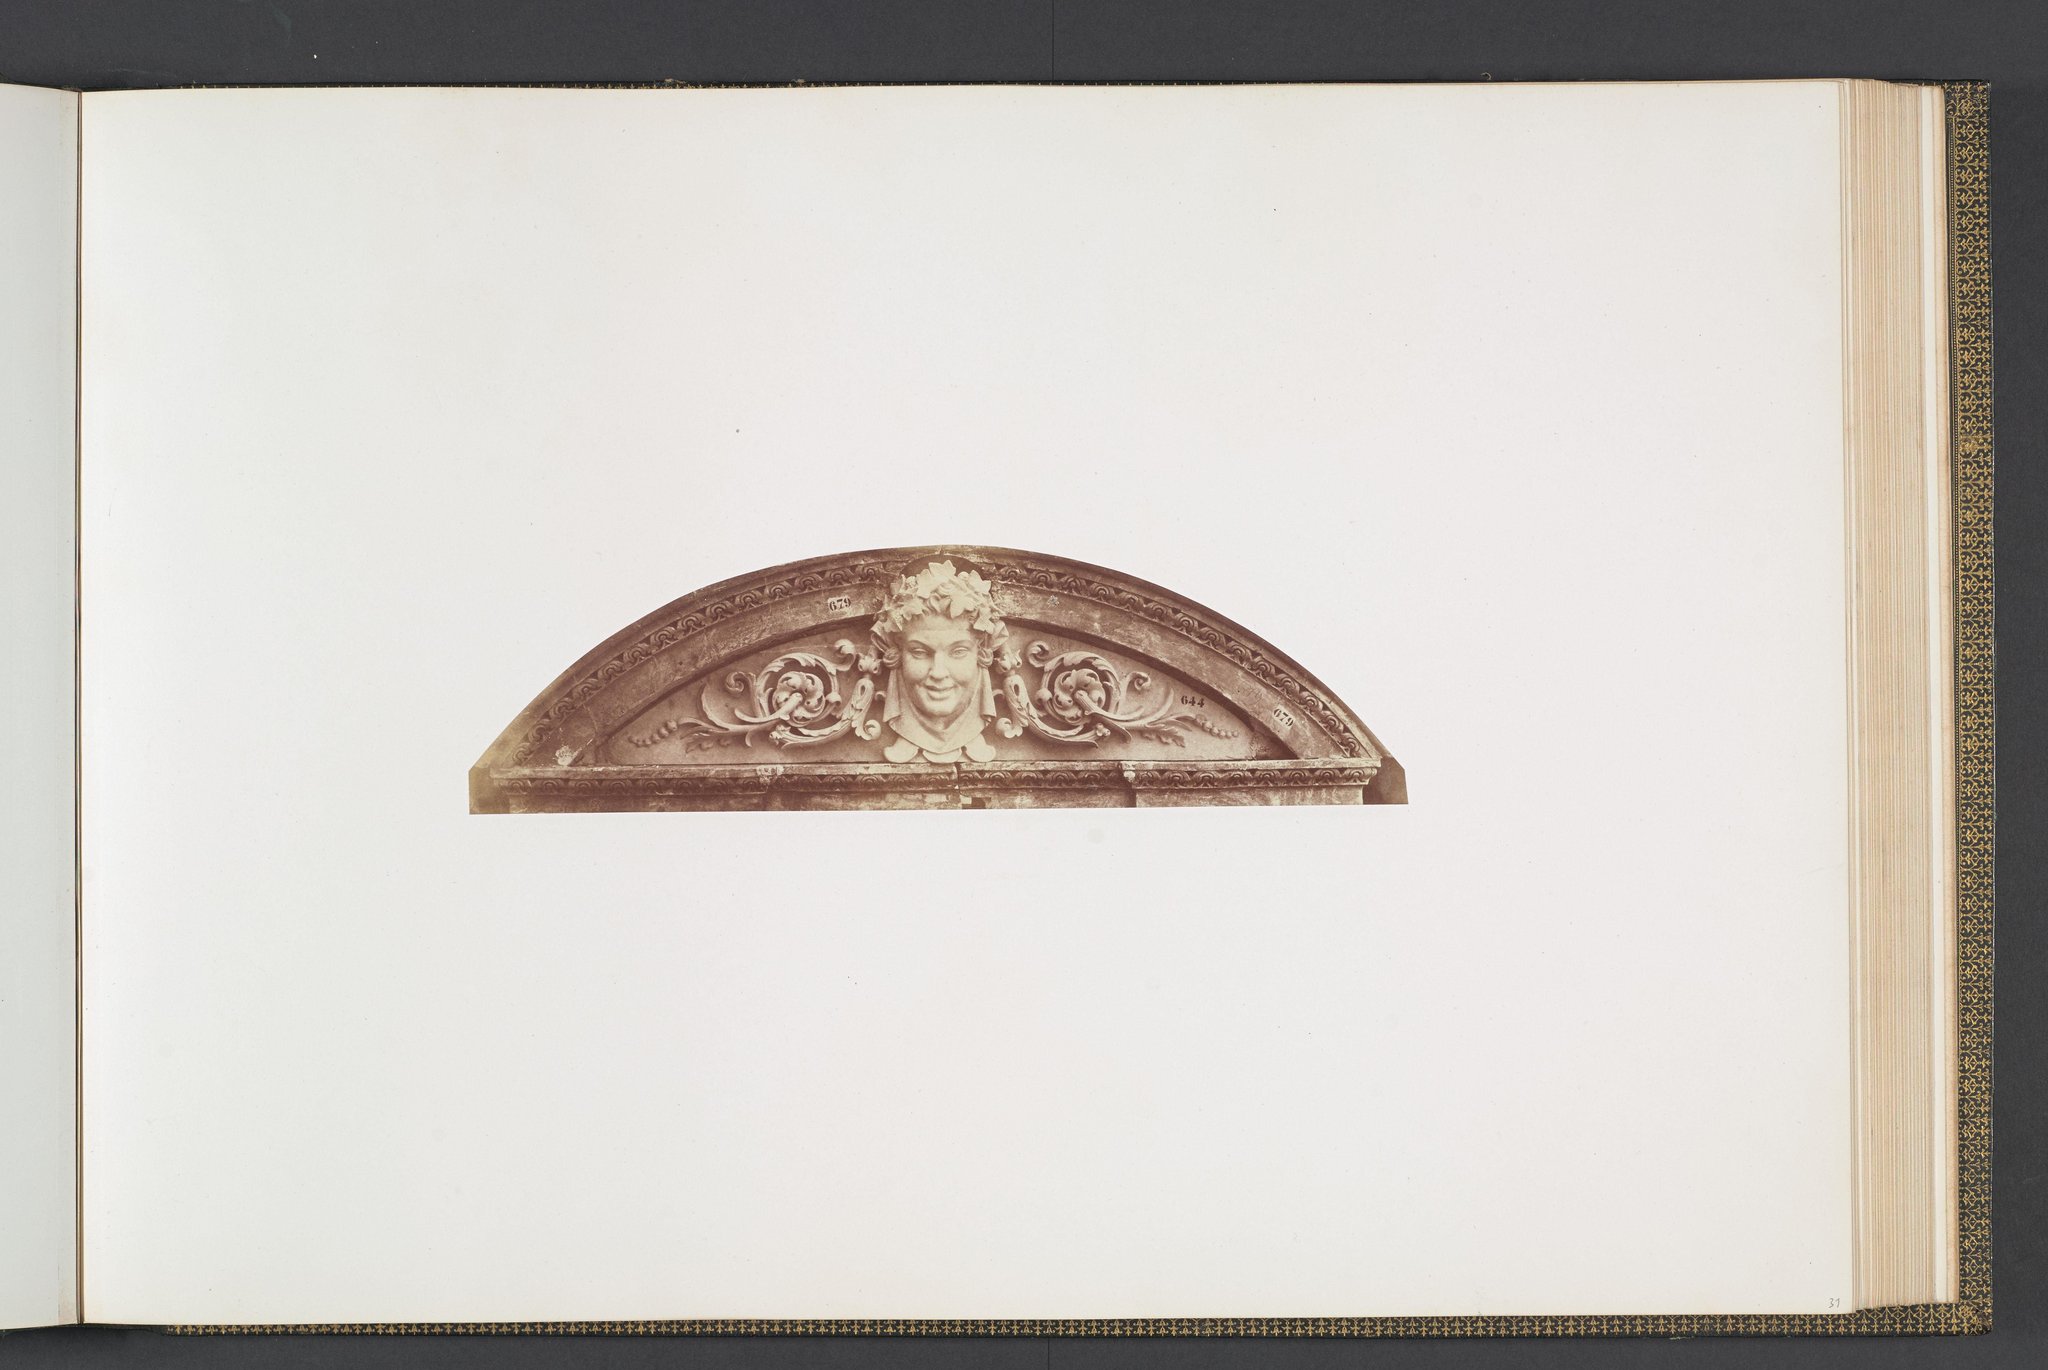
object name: photograph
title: Gipsmodel voor beeldhouwwerk op het Palais du Louvre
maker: édouard denis baldus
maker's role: fotograaf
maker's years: 1813-1889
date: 1855-1857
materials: paper, photographic support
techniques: salted paper print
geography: paris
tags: other architectural details (with name), permanent exhibition, museum, paris, tuileries palace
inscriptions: number: ‘679 en 644’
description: Onderdeel van Réunion des Tuileries au Louvre 1852-1857, album 3.